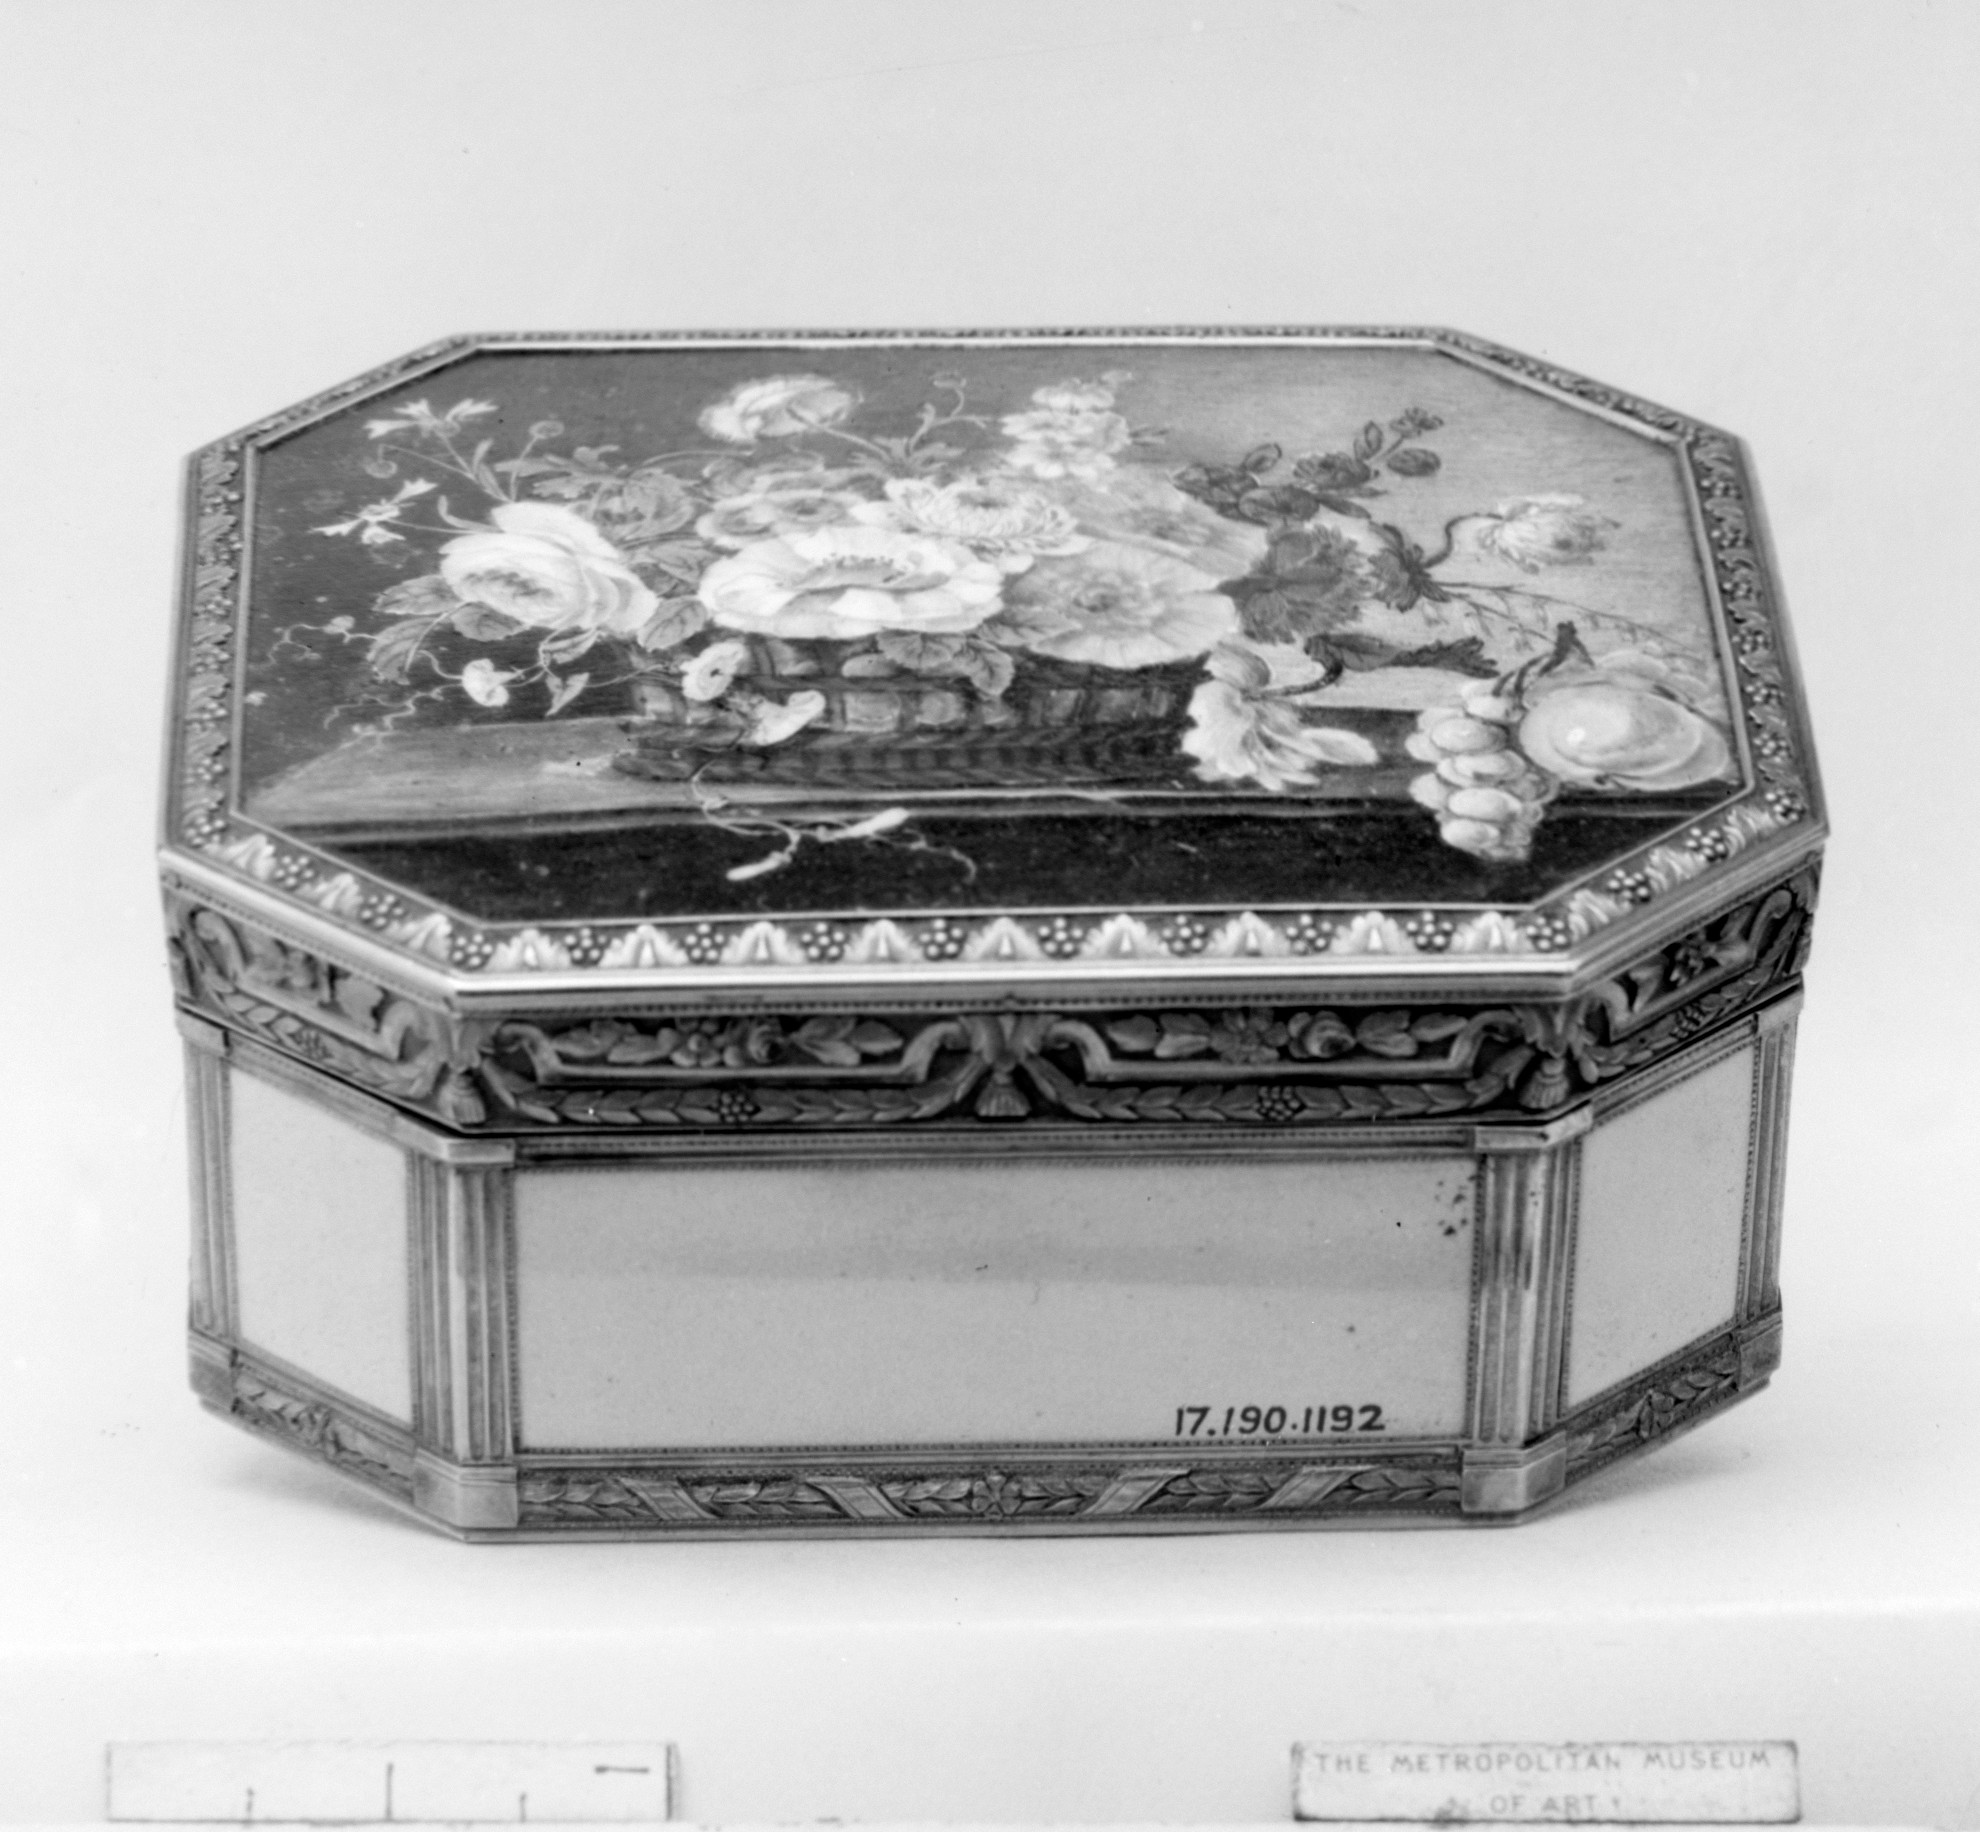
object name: snuffbox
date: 1801-1900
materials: enamel, gold, hard paste porcelain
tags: fruit,flowers